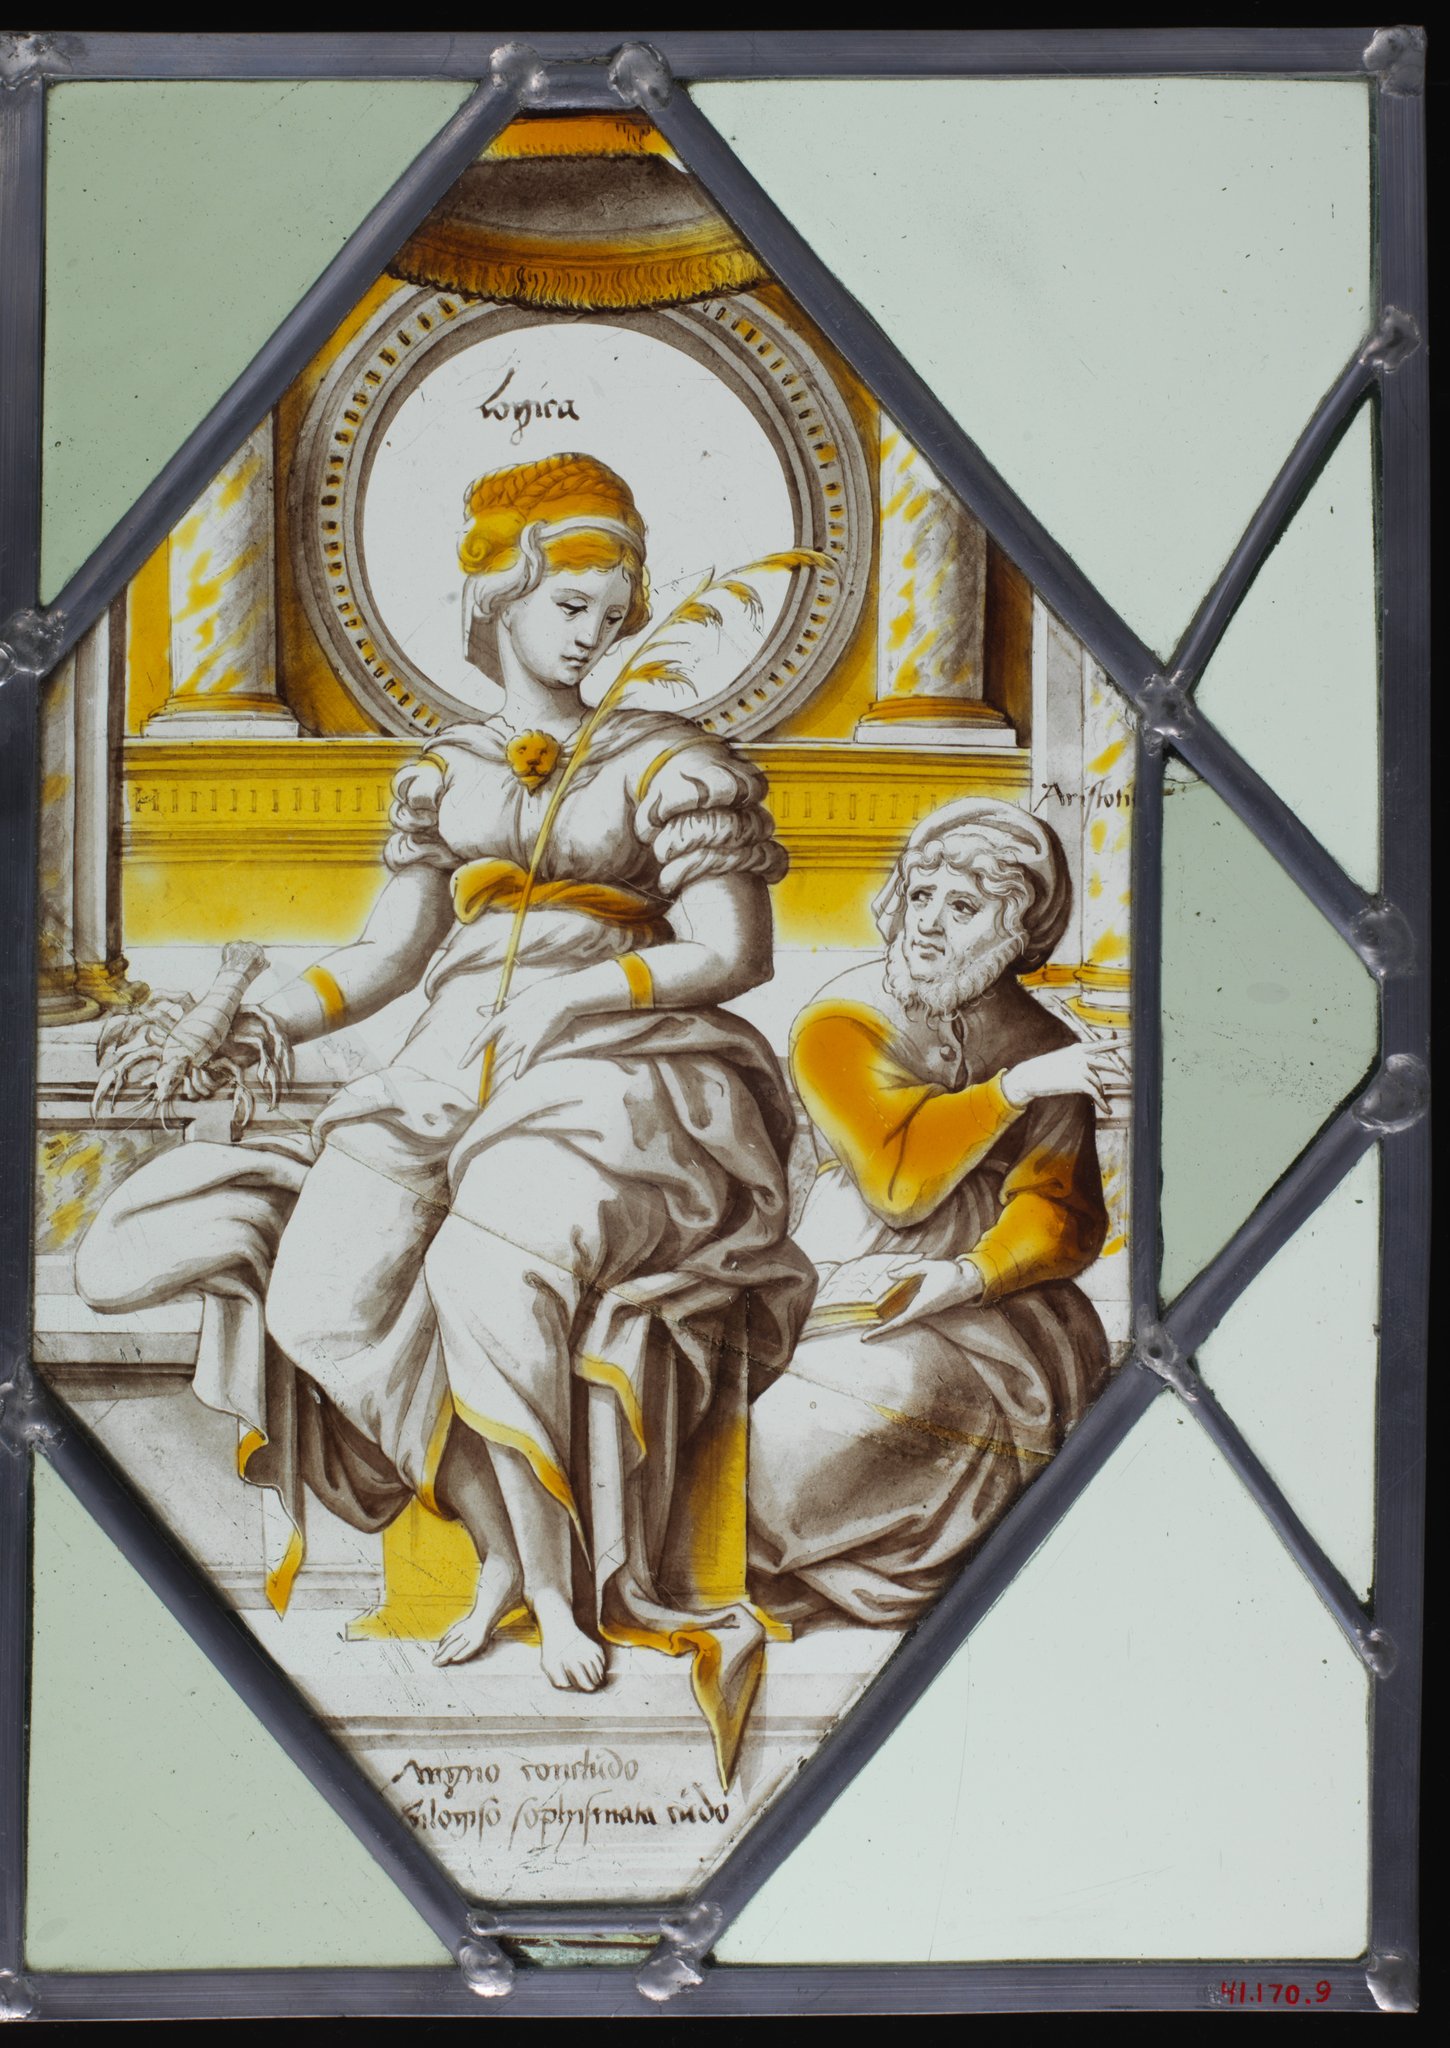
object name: panel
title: Logic (one of a pair)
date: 1767-1866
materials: glass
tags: women